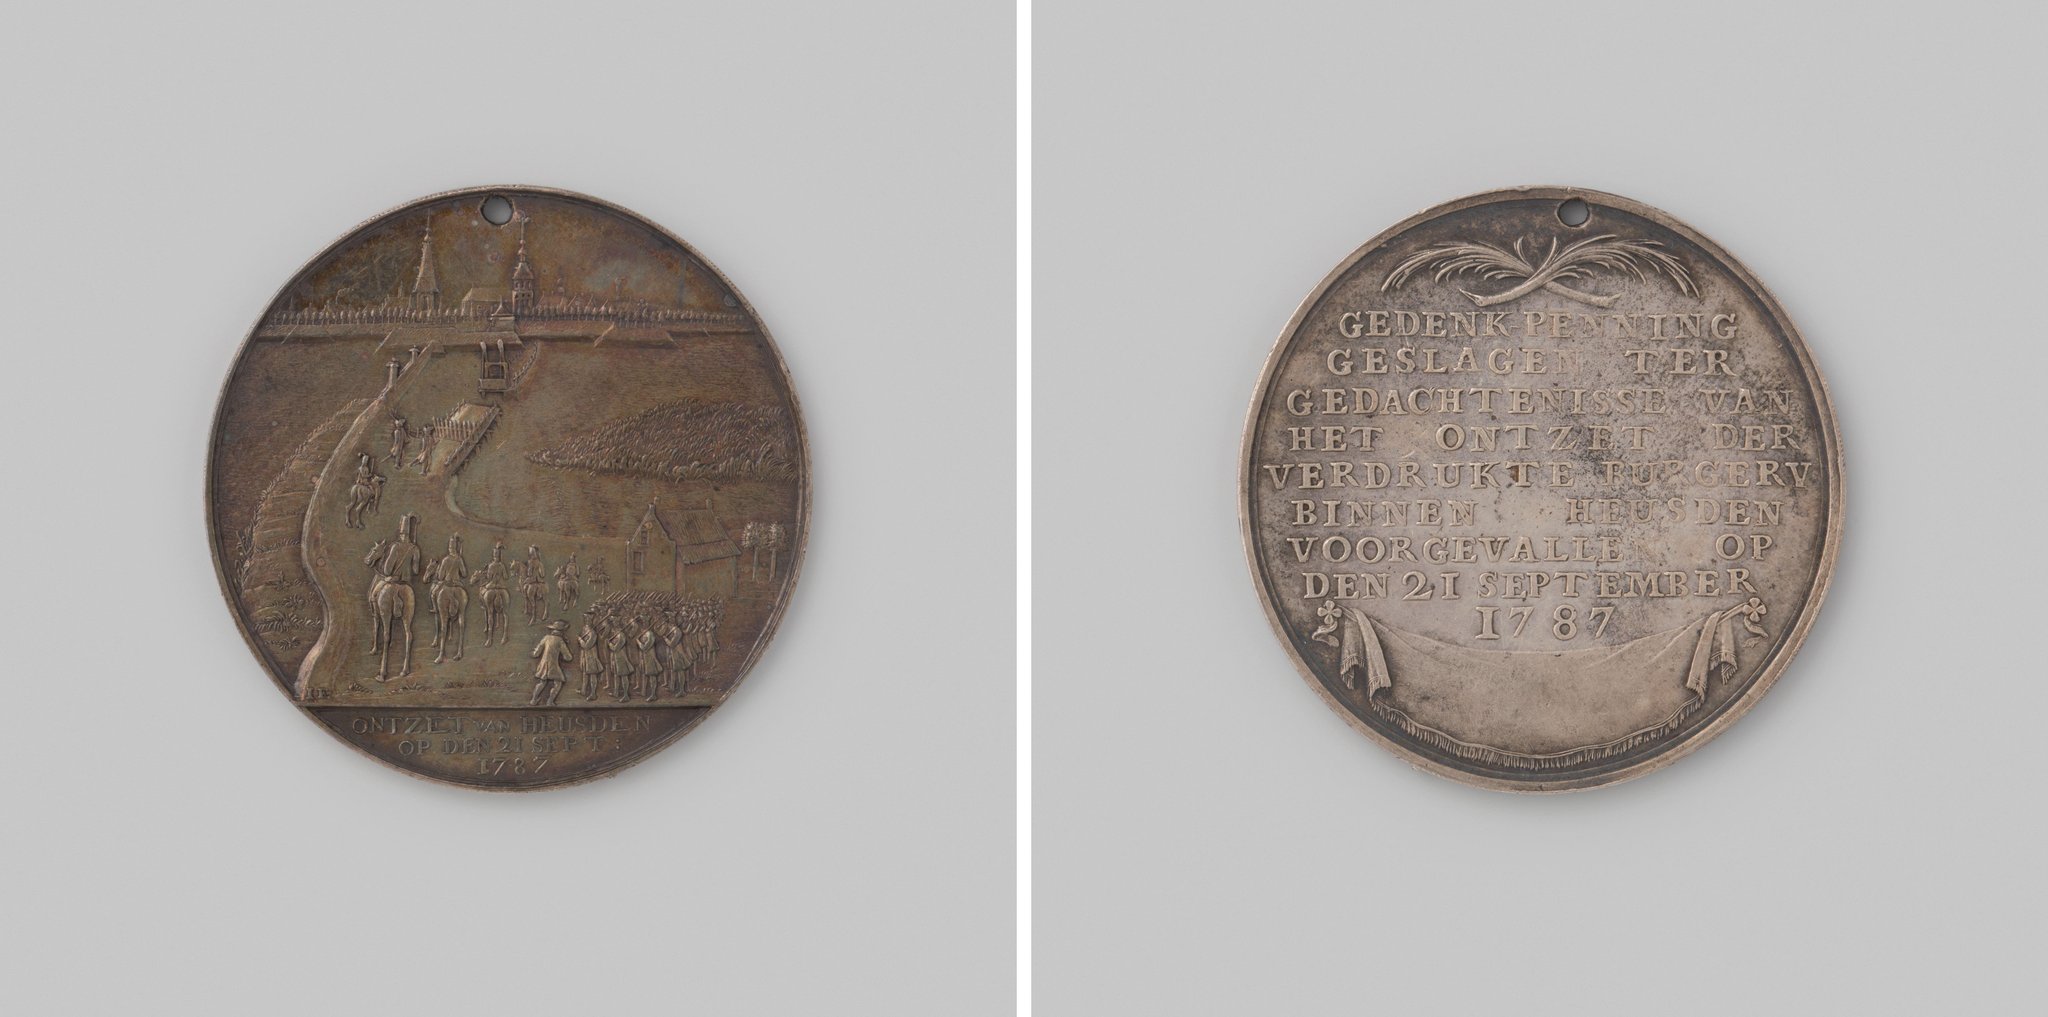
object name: history medal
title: Ontzet van Heusden 1787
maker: j. everts (tekenaar)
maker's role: draughtsman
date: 1787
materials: silver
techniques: pierced, pressing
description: Zilveren penning met kleine doorboring, op de voorzijde Pruisische militairen op een dijk voor de wallen van Heusden, met afsnedetekst, op de keerzijde negen regels tekst , bovenaan twee gekruiste palmtakken, onderaan een gedrapeerd kleed.